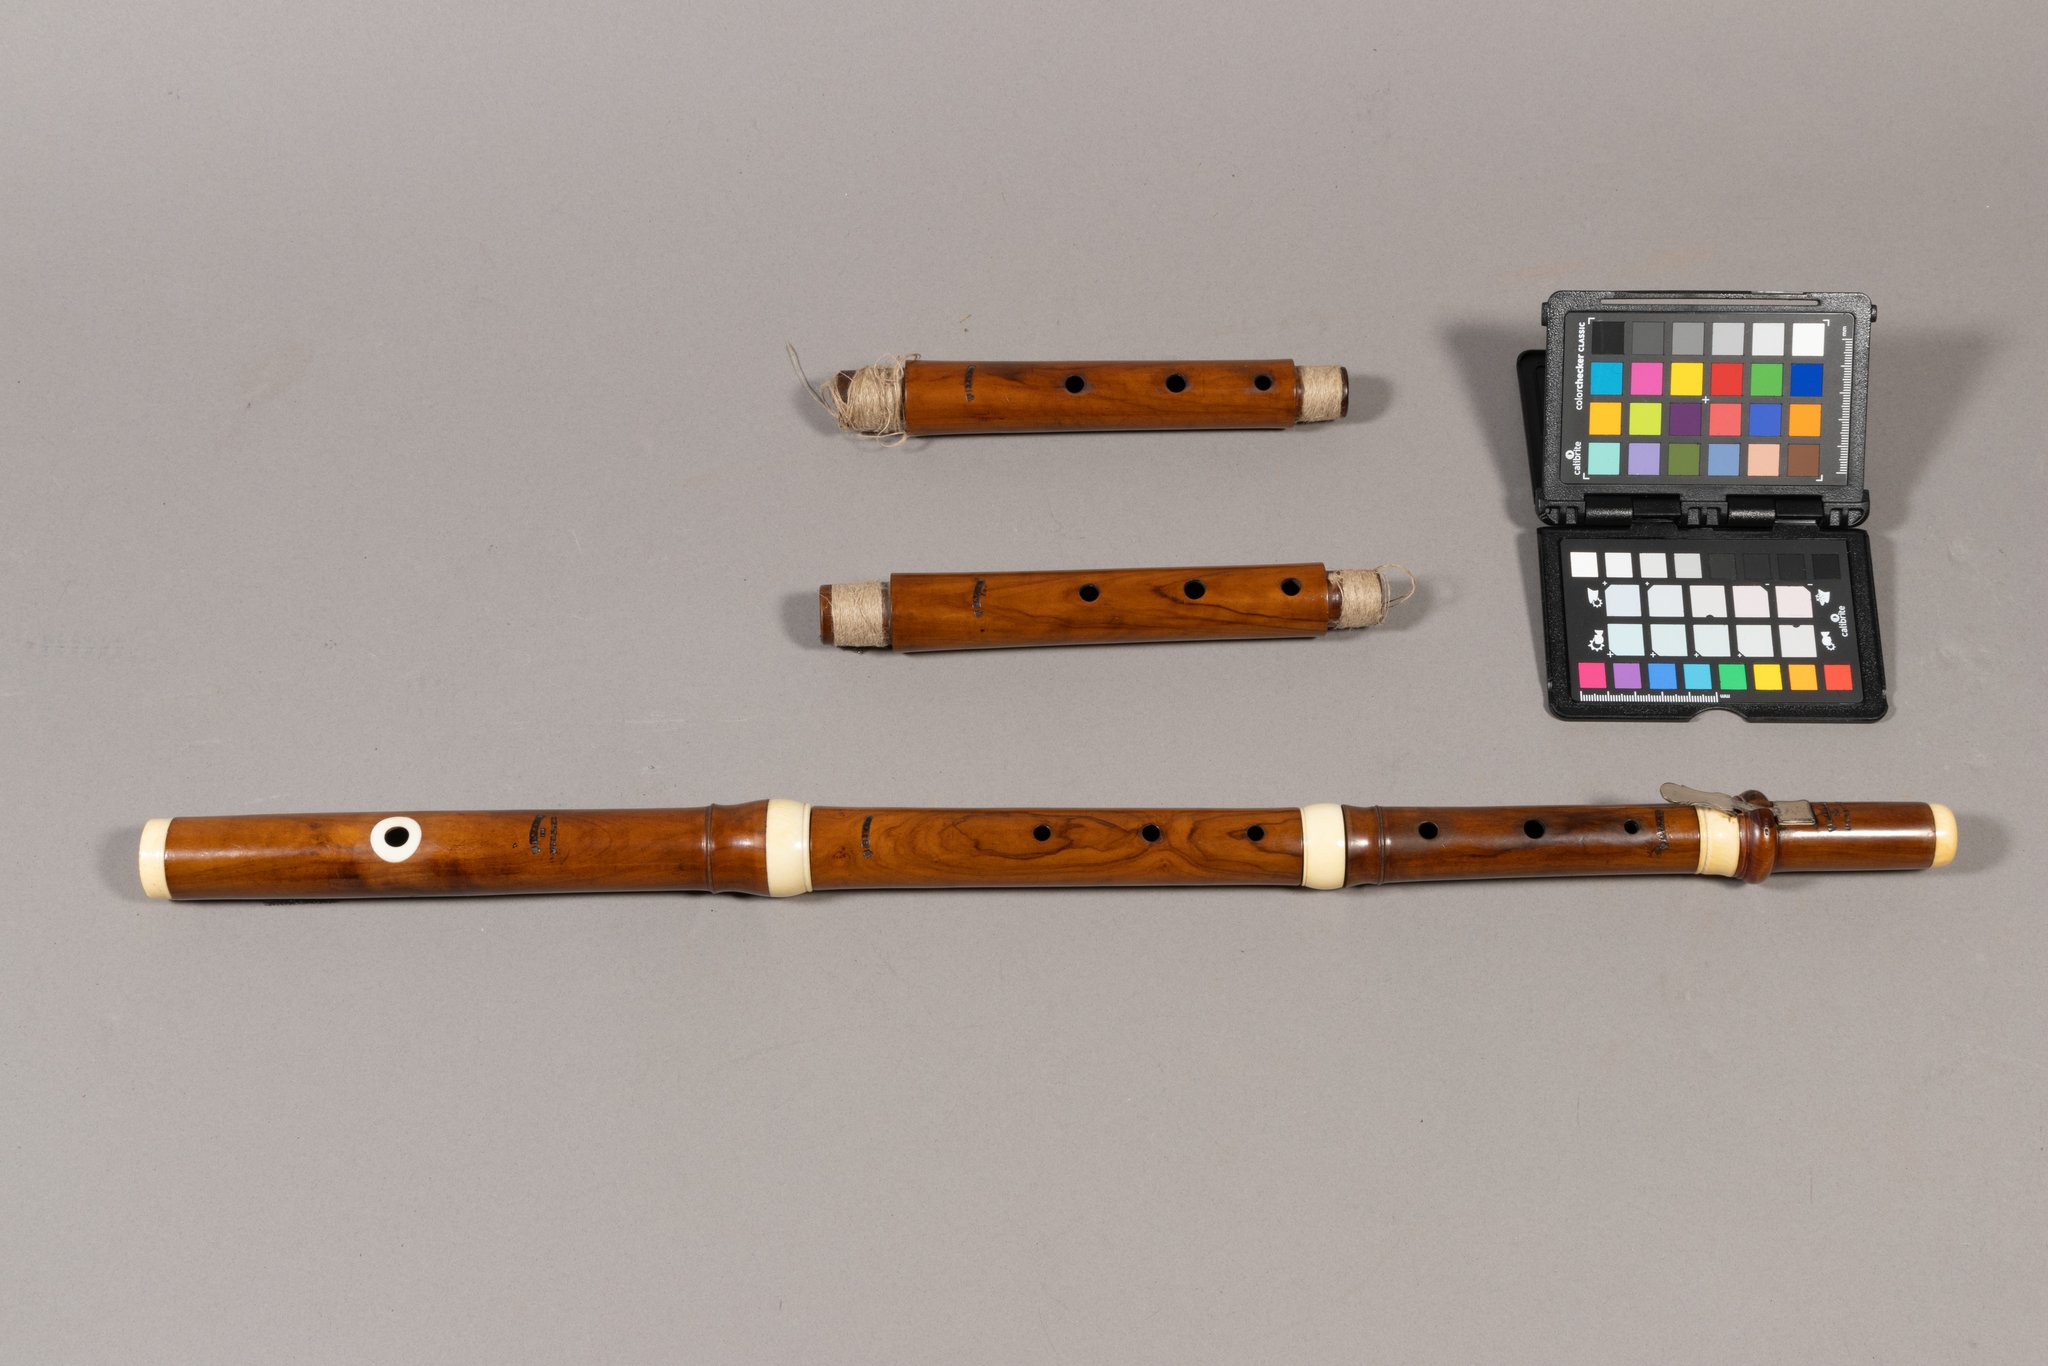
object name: transverse flute in d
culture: dutch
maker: franciscus eerens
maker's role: maker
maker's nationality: dutch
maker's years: 1712-1784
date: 1734-1766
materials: ivory, silver, wood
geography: netherlands